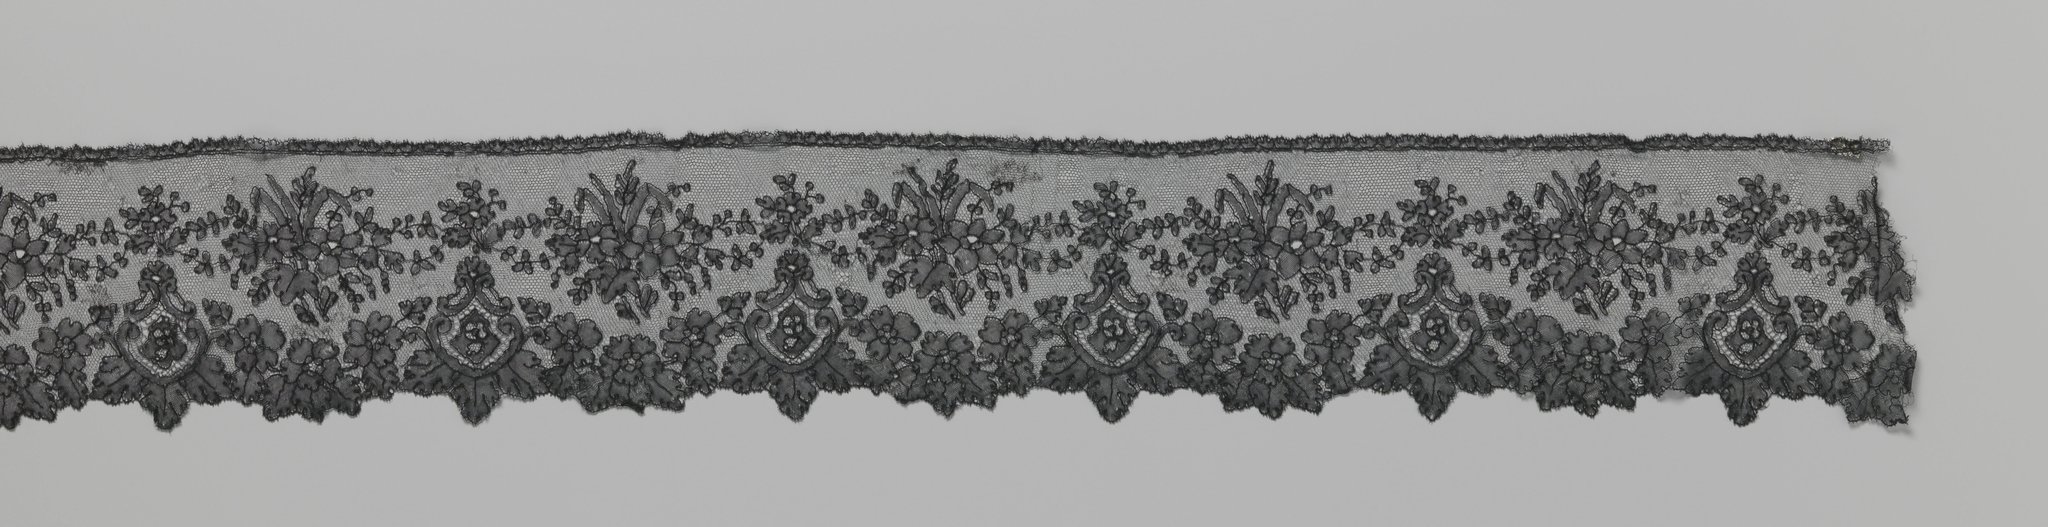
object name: strip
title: Japonstrook van kloskant met de schildvormige medaillons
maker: Anonymous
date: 1850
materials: silk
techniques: lace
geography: bayeux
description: Japonstrook van zwarte kloskant: Chantilly-kant. Op een open mazenfond staan gesloten motieven los van elkaar gegroepeerd. Op de knooppunten der schulpen rijzen drie symmetrische schildvormige medaillons op, die gevat zijn in twee paar c-voluten. Boven de schulpen komt een grote, boven de medaillons een kleine bloemtoef voor, met geknakte bloembladeren als bekroning. De binnenrand is versierd met een keten van hartvormige blaadjes.